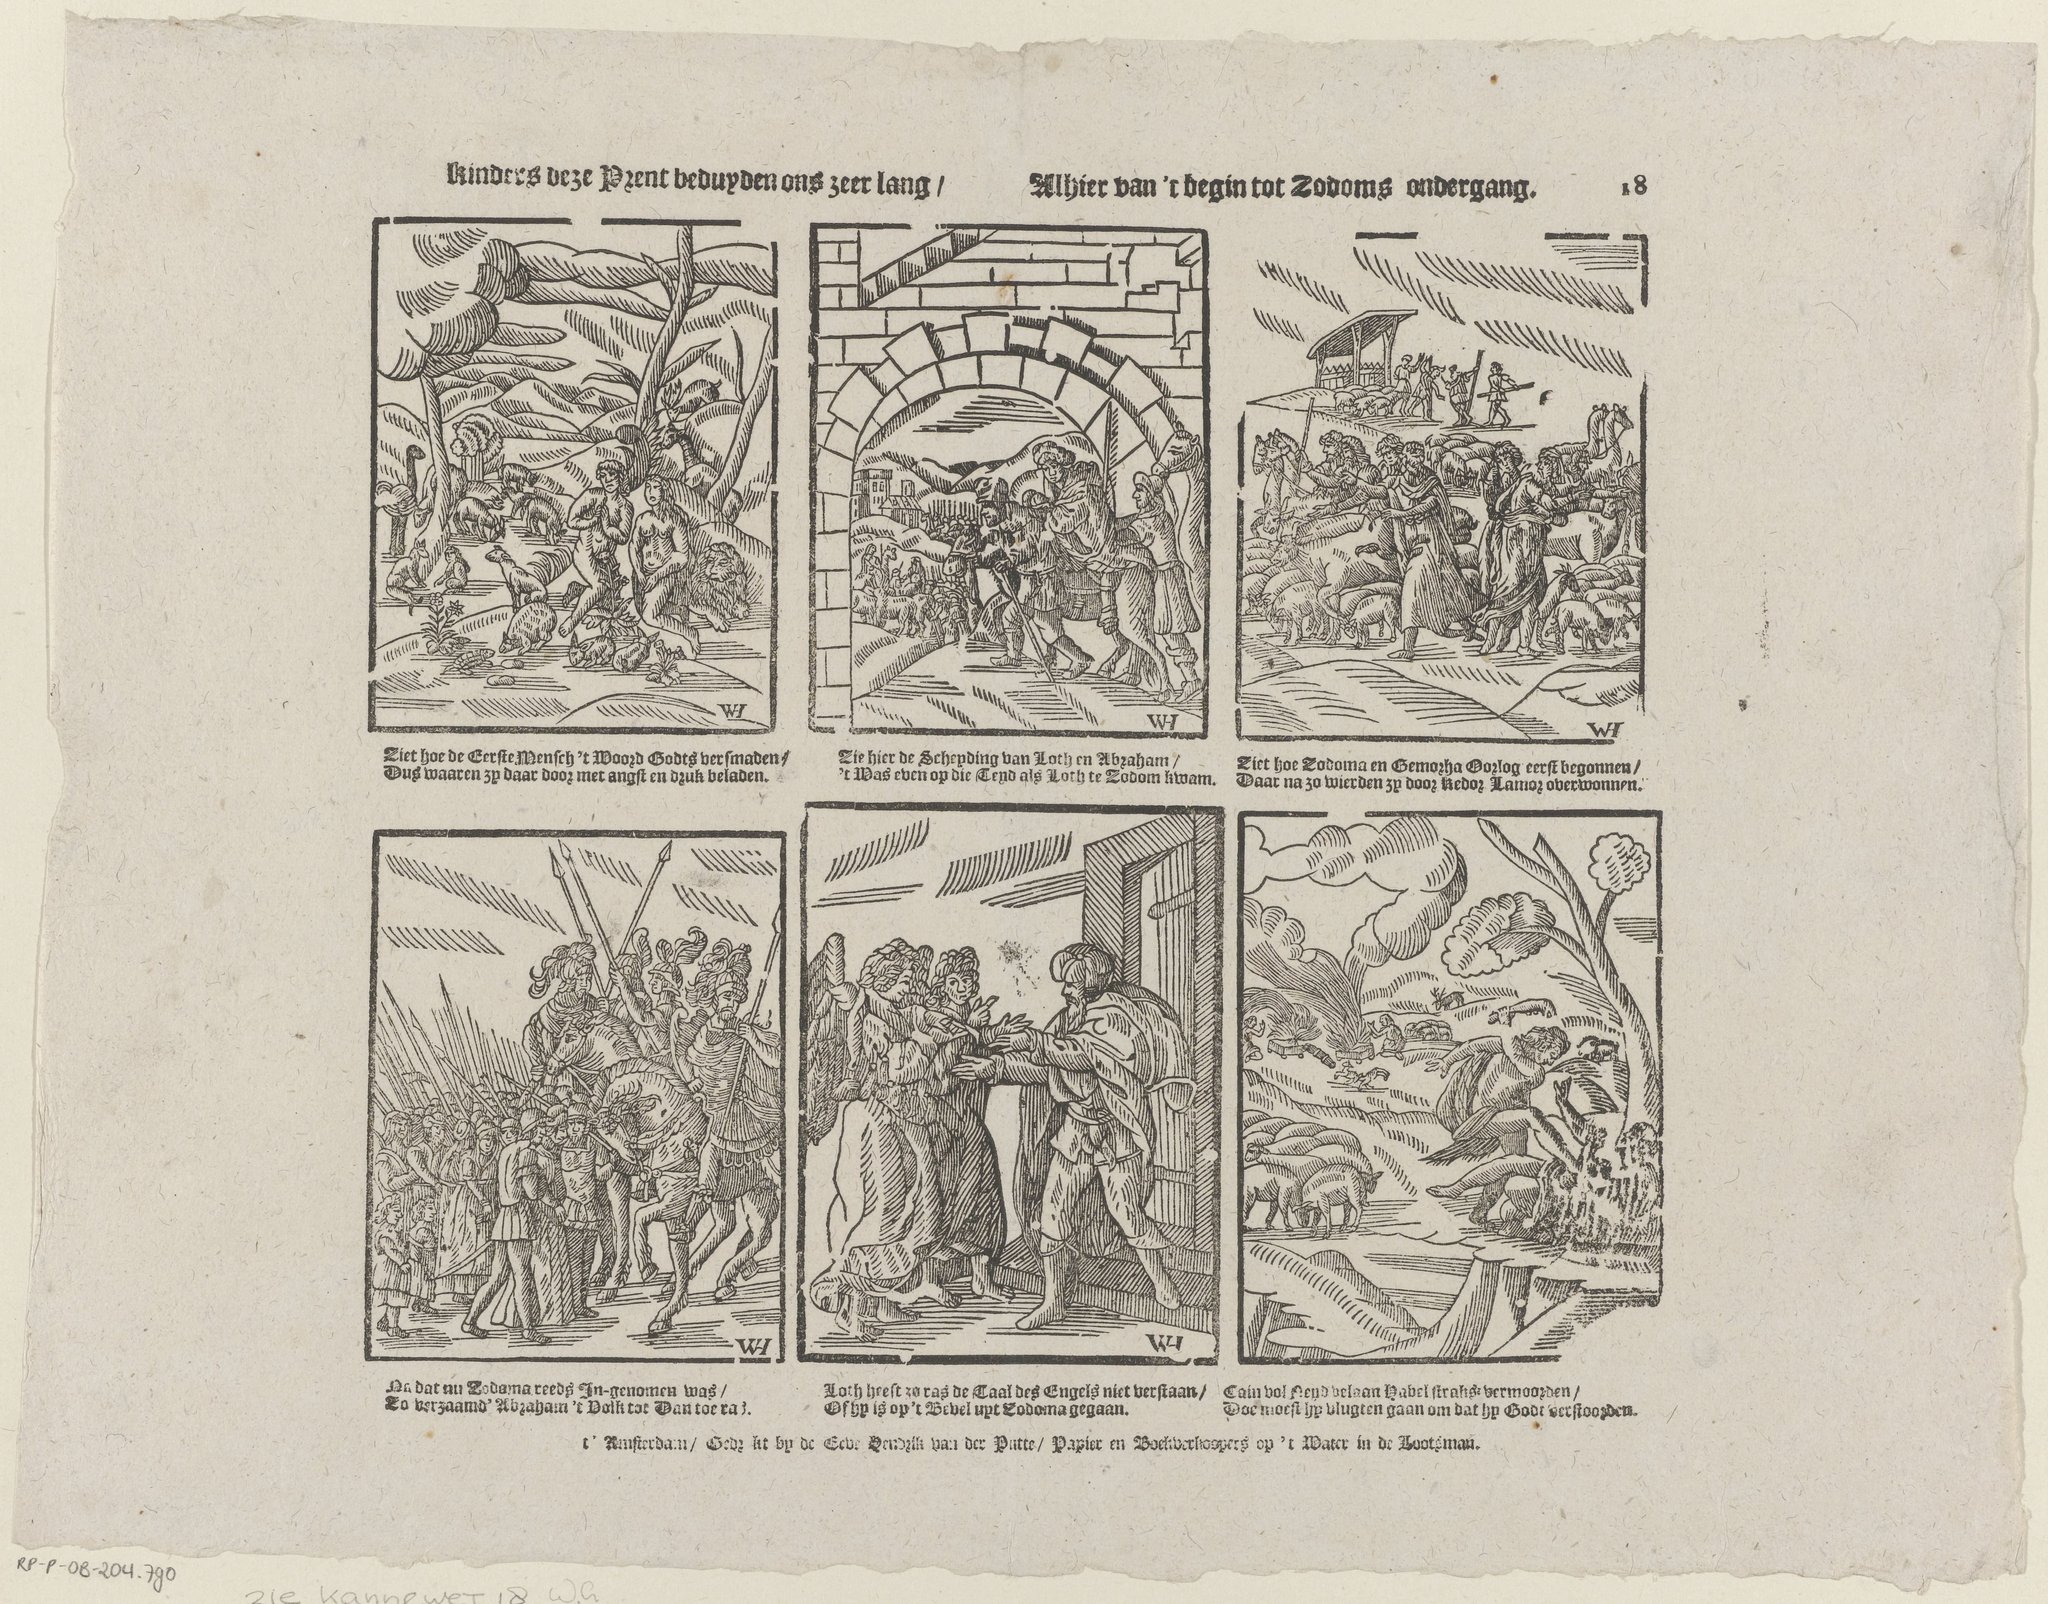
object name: popular print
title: Kinders deze prent beduyden ons zeer lang / Alhier van 't begin tot Zodoms ondergang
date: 1767-1793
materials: paper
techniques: letterpress printing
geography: netherlands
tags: old testament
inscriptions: collector's mark: Lugt 2760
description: Blad met 6 voorstellingen van verhalen uit het Oude Testament, zoals Adam en Eva in het paradijs en de dood van Abel. Onder elke afbeelding een tweeregelig vers. Genummerd rechtsboven: 18.